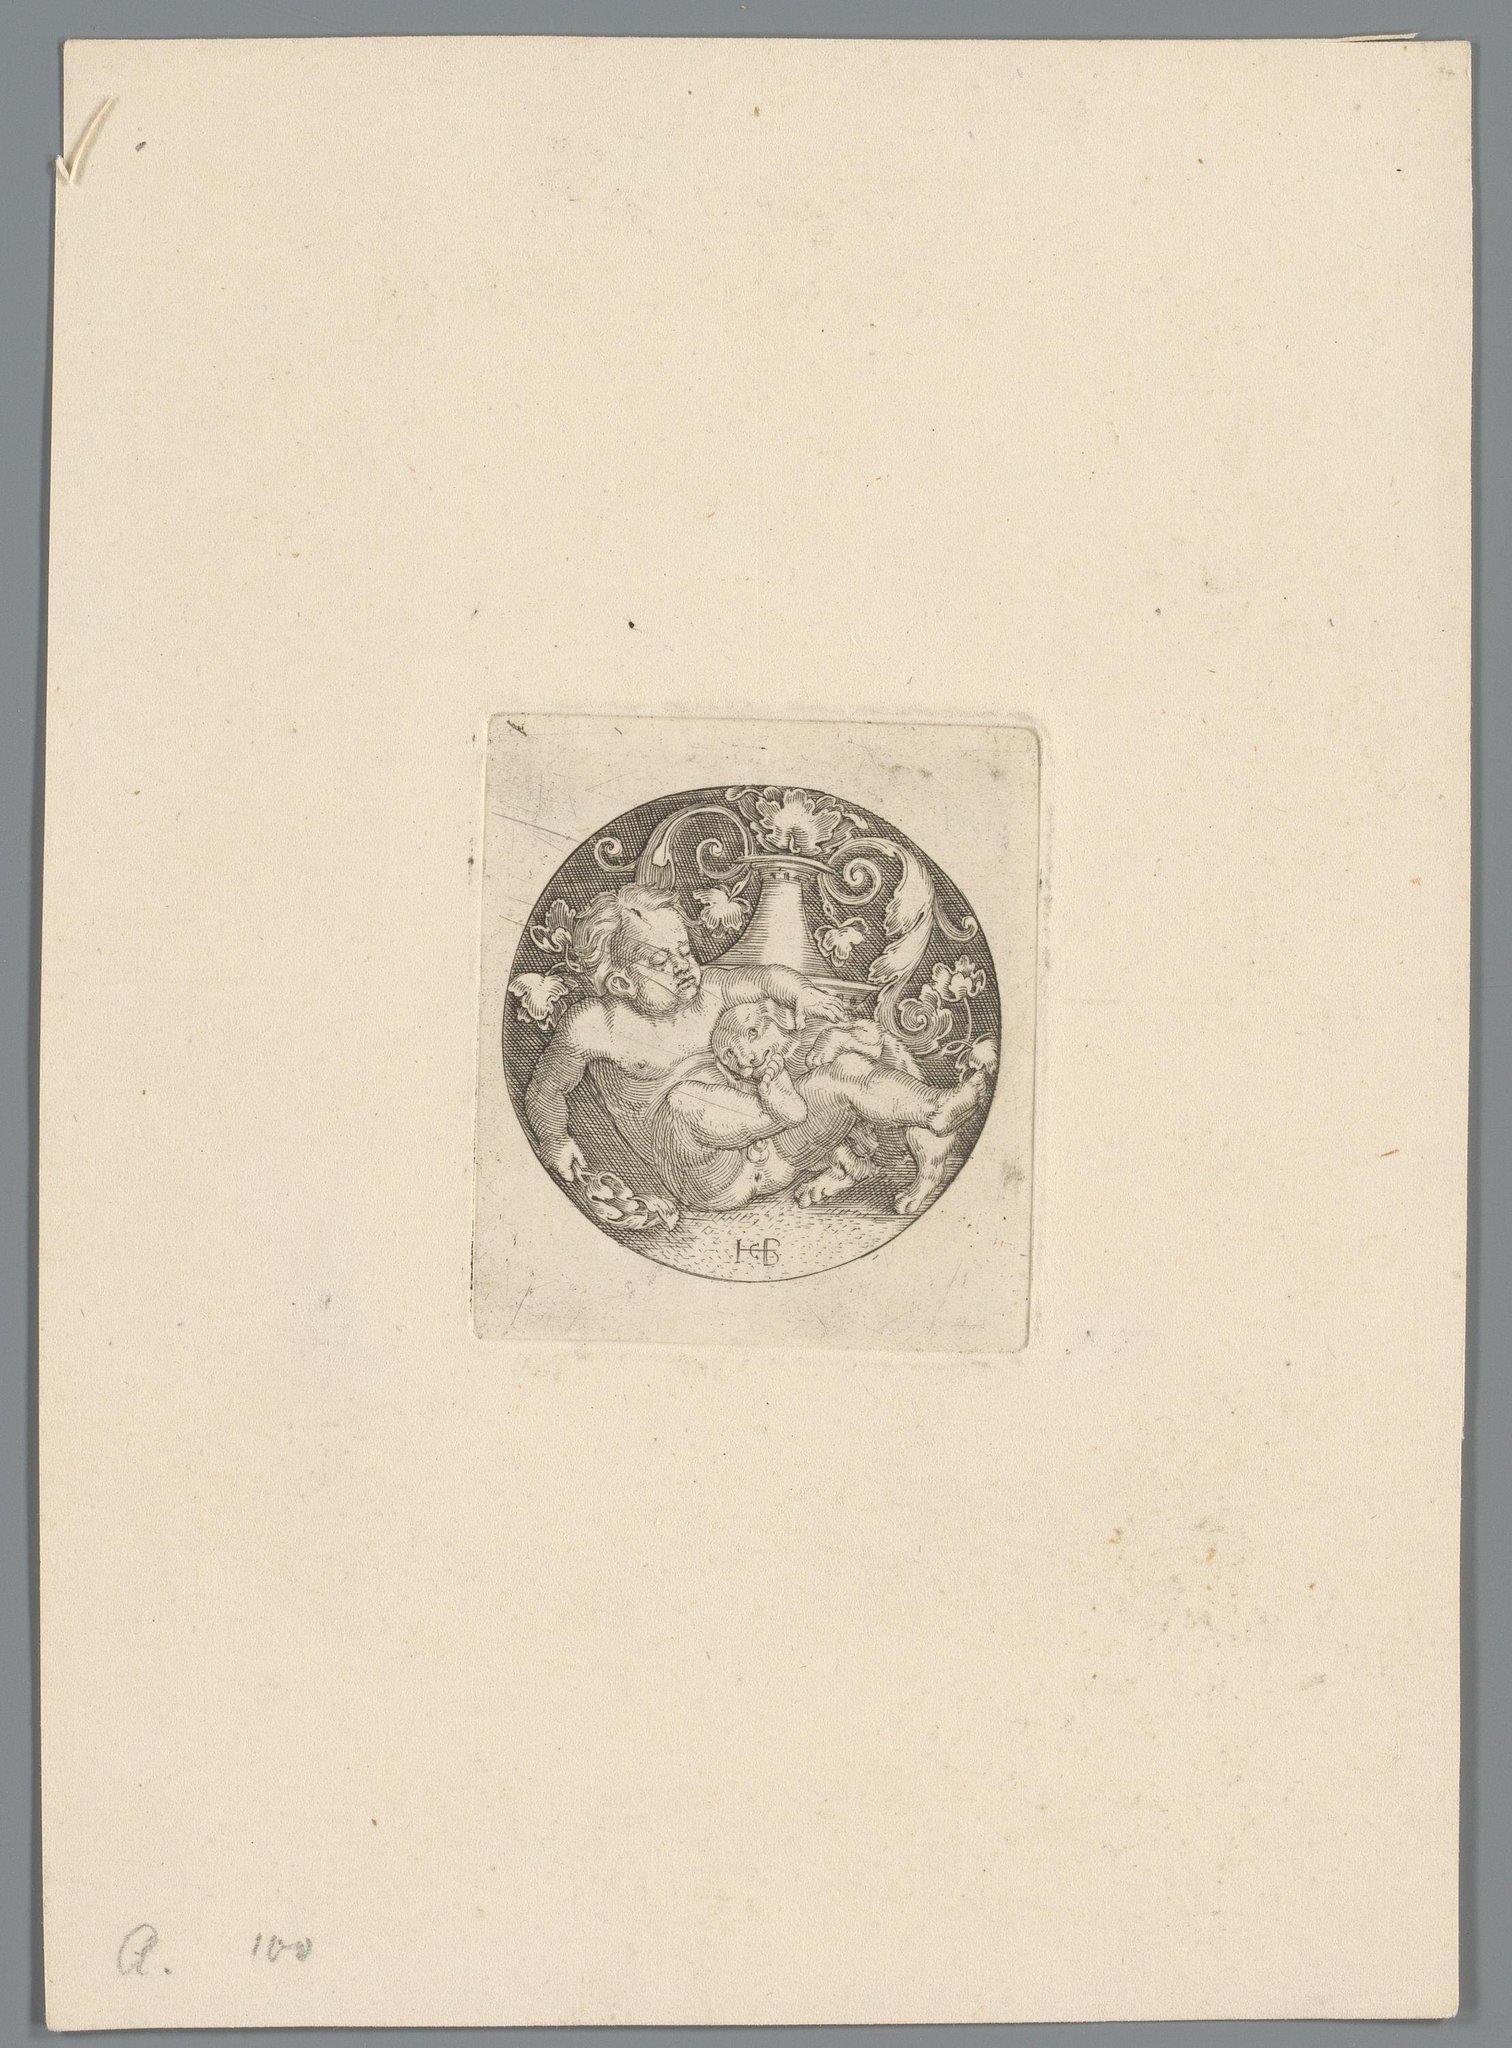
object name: print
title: Kind spelend met een hond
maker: jacob binck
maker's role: painter, print maker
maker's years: 1494-1569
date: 1510-1569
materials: paper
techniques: engraving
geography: germany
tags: toddler (male), dog